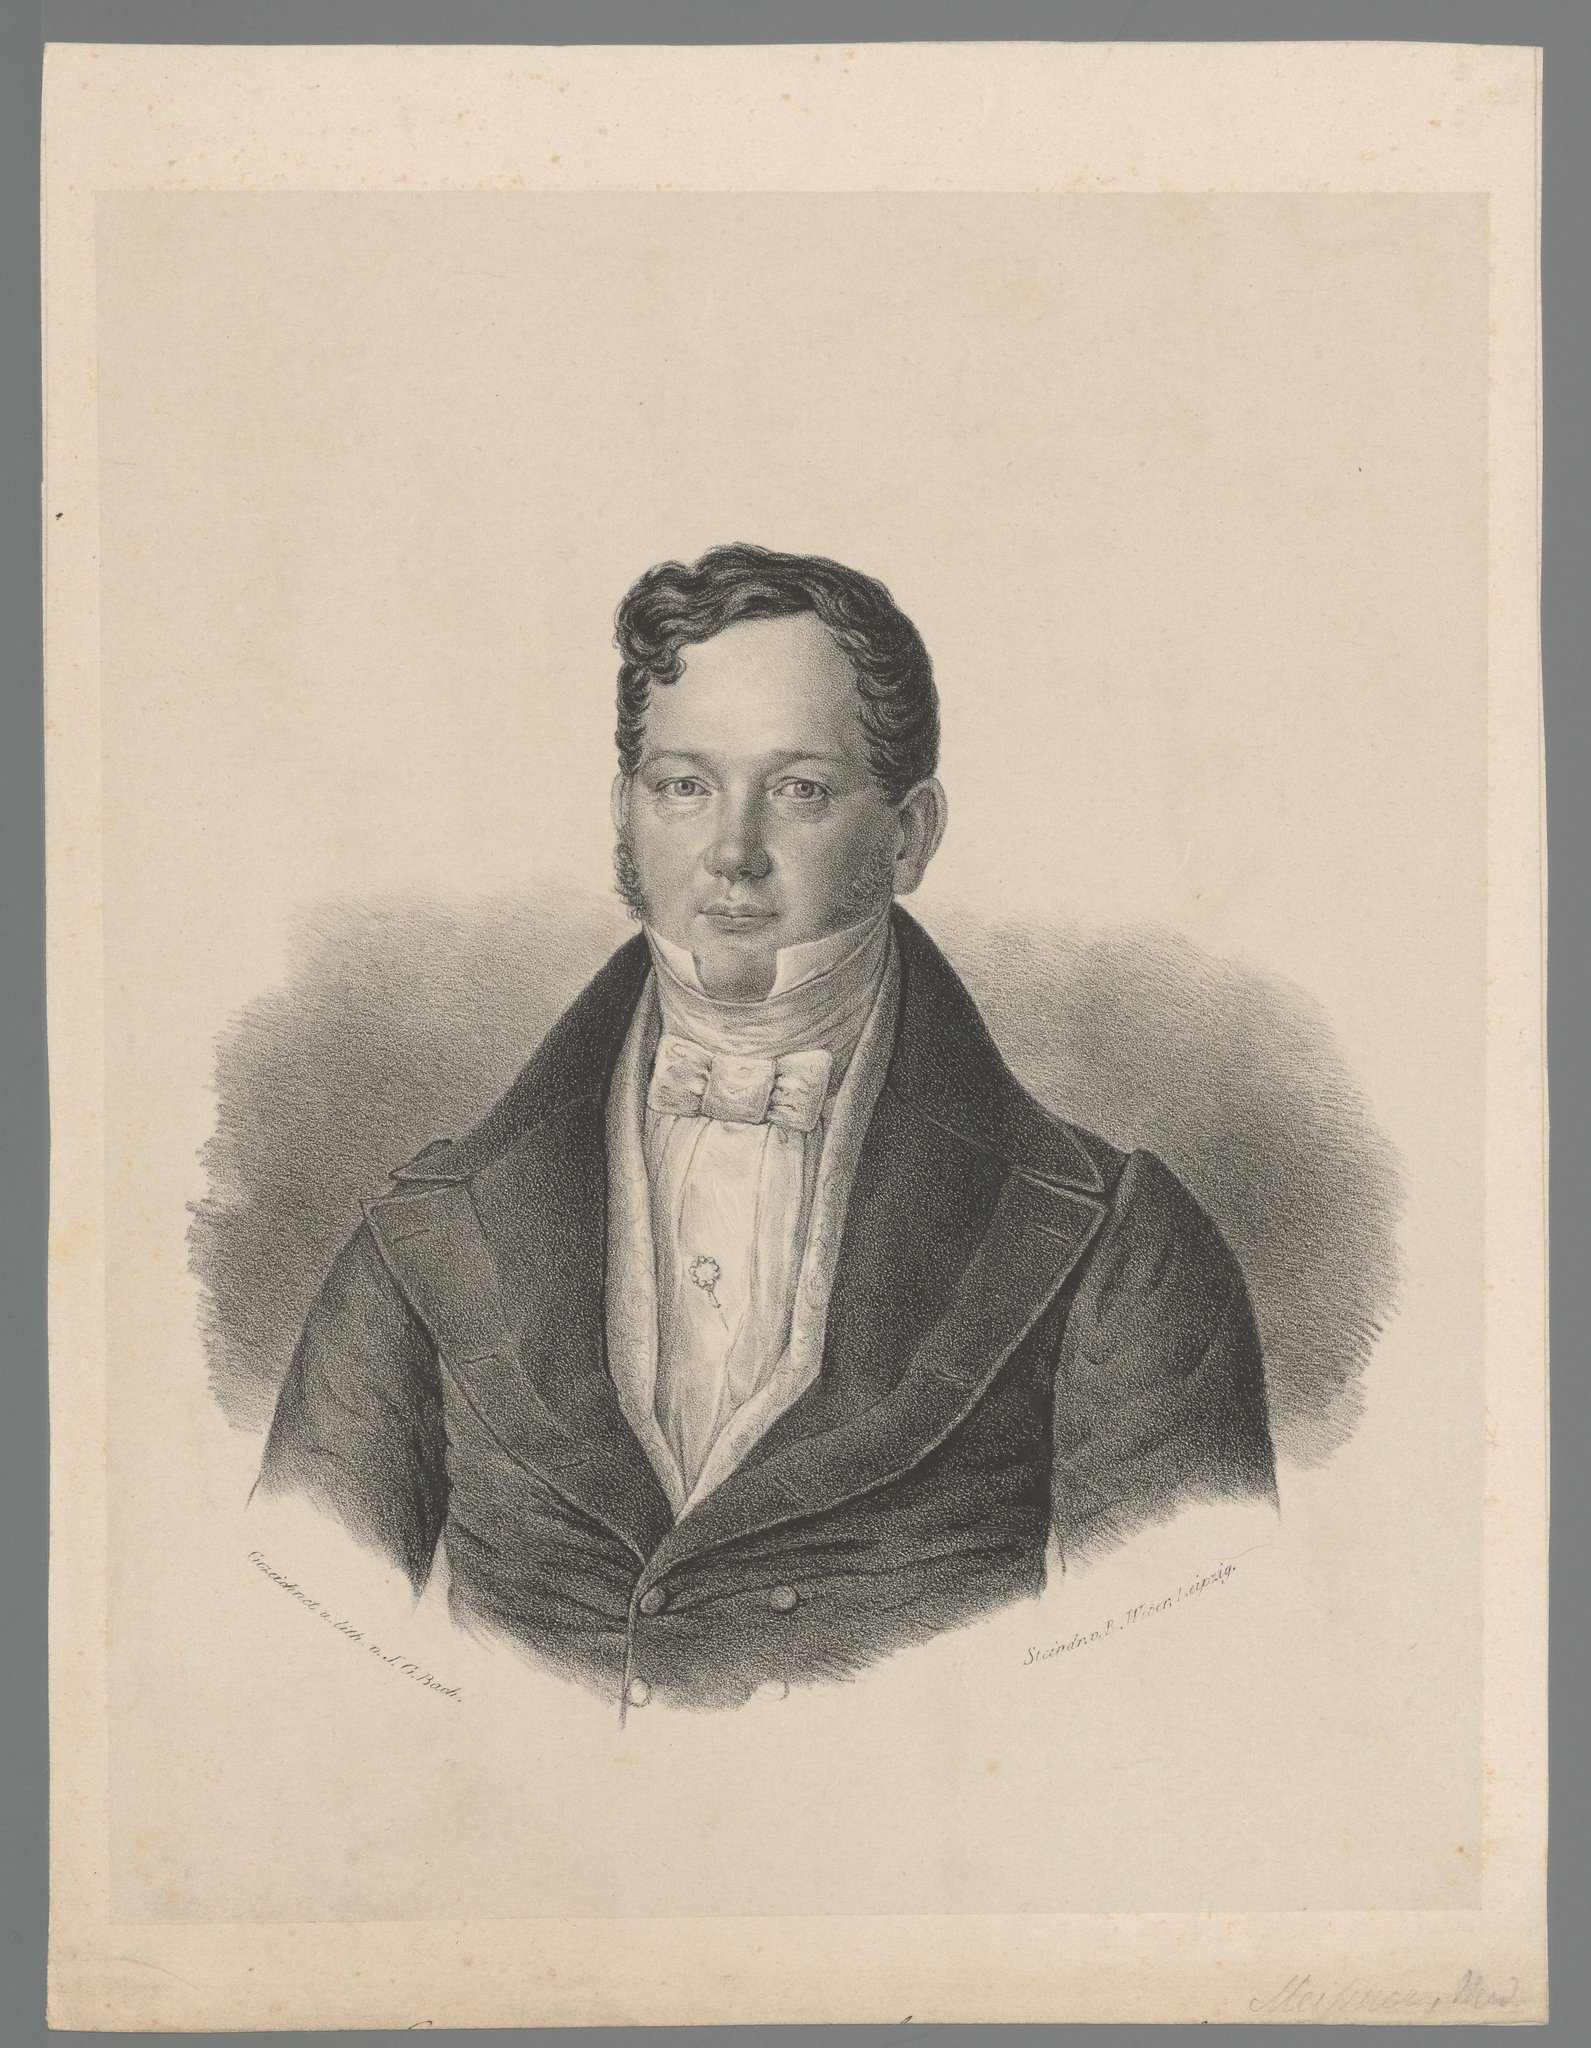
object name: print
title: Portret van Rudolf Meissner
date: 1820-1880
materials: paper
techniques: lithograph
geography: leipzig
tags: historical persons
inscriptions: collector's mark: Lugt 2228